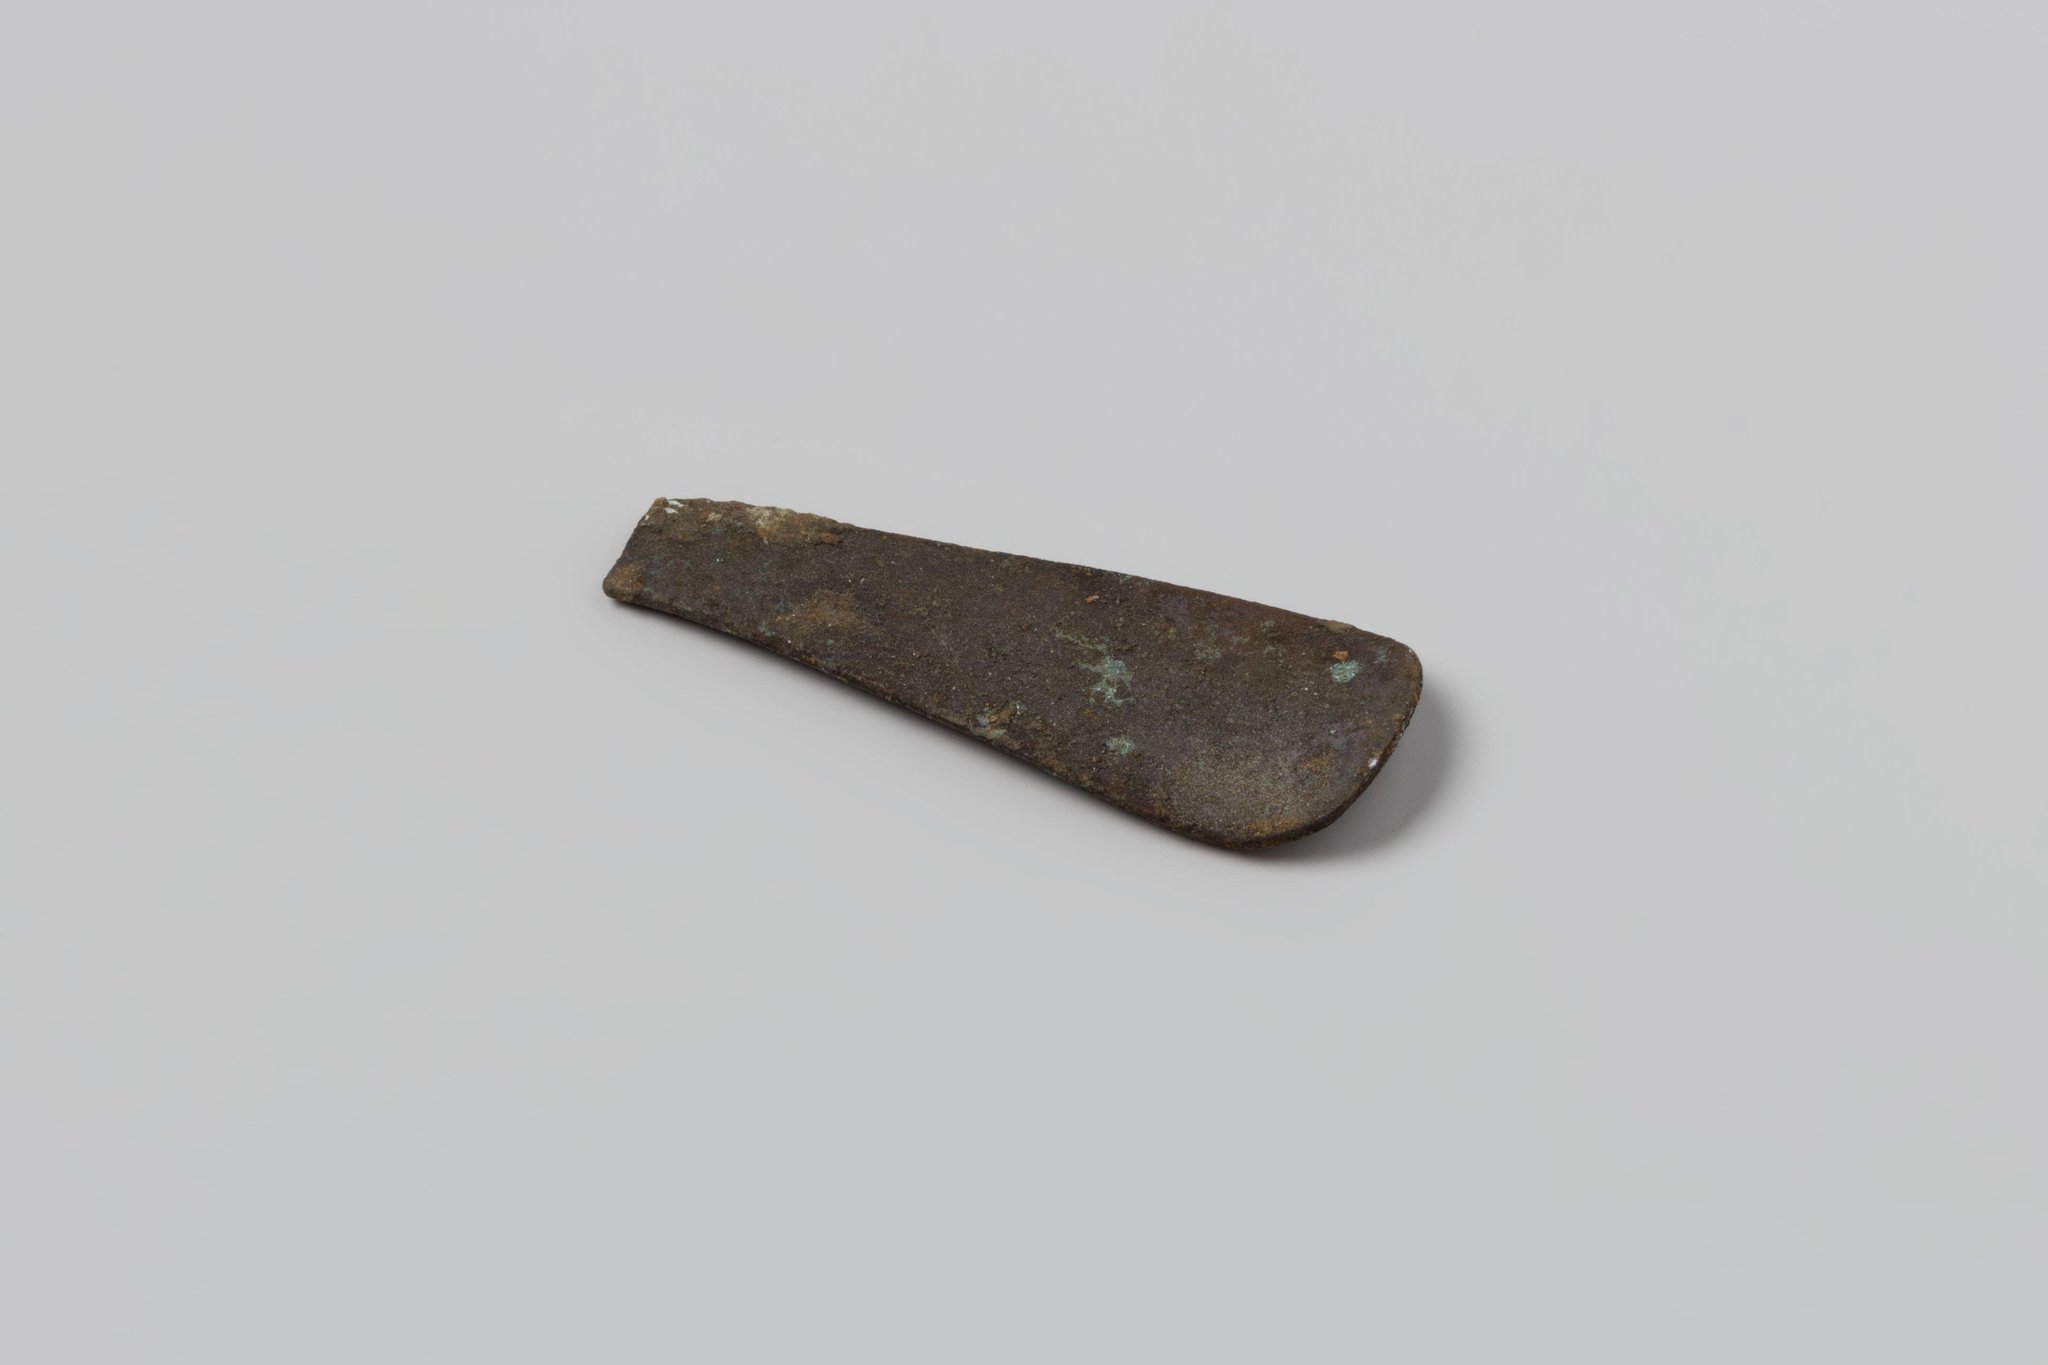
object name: spoon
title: Fragment steel van vork of lepel uit het wrak van de Oost-Indiëvaarder Hollandia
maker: Anonymous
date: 1700-1743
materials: copper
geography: netherlands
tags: verenigde oostindische compagnie, hollandia (schip), annet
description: Cutlery, fragment: stem of fork or spoon; fragm, id. NG 1980-27H1373a.